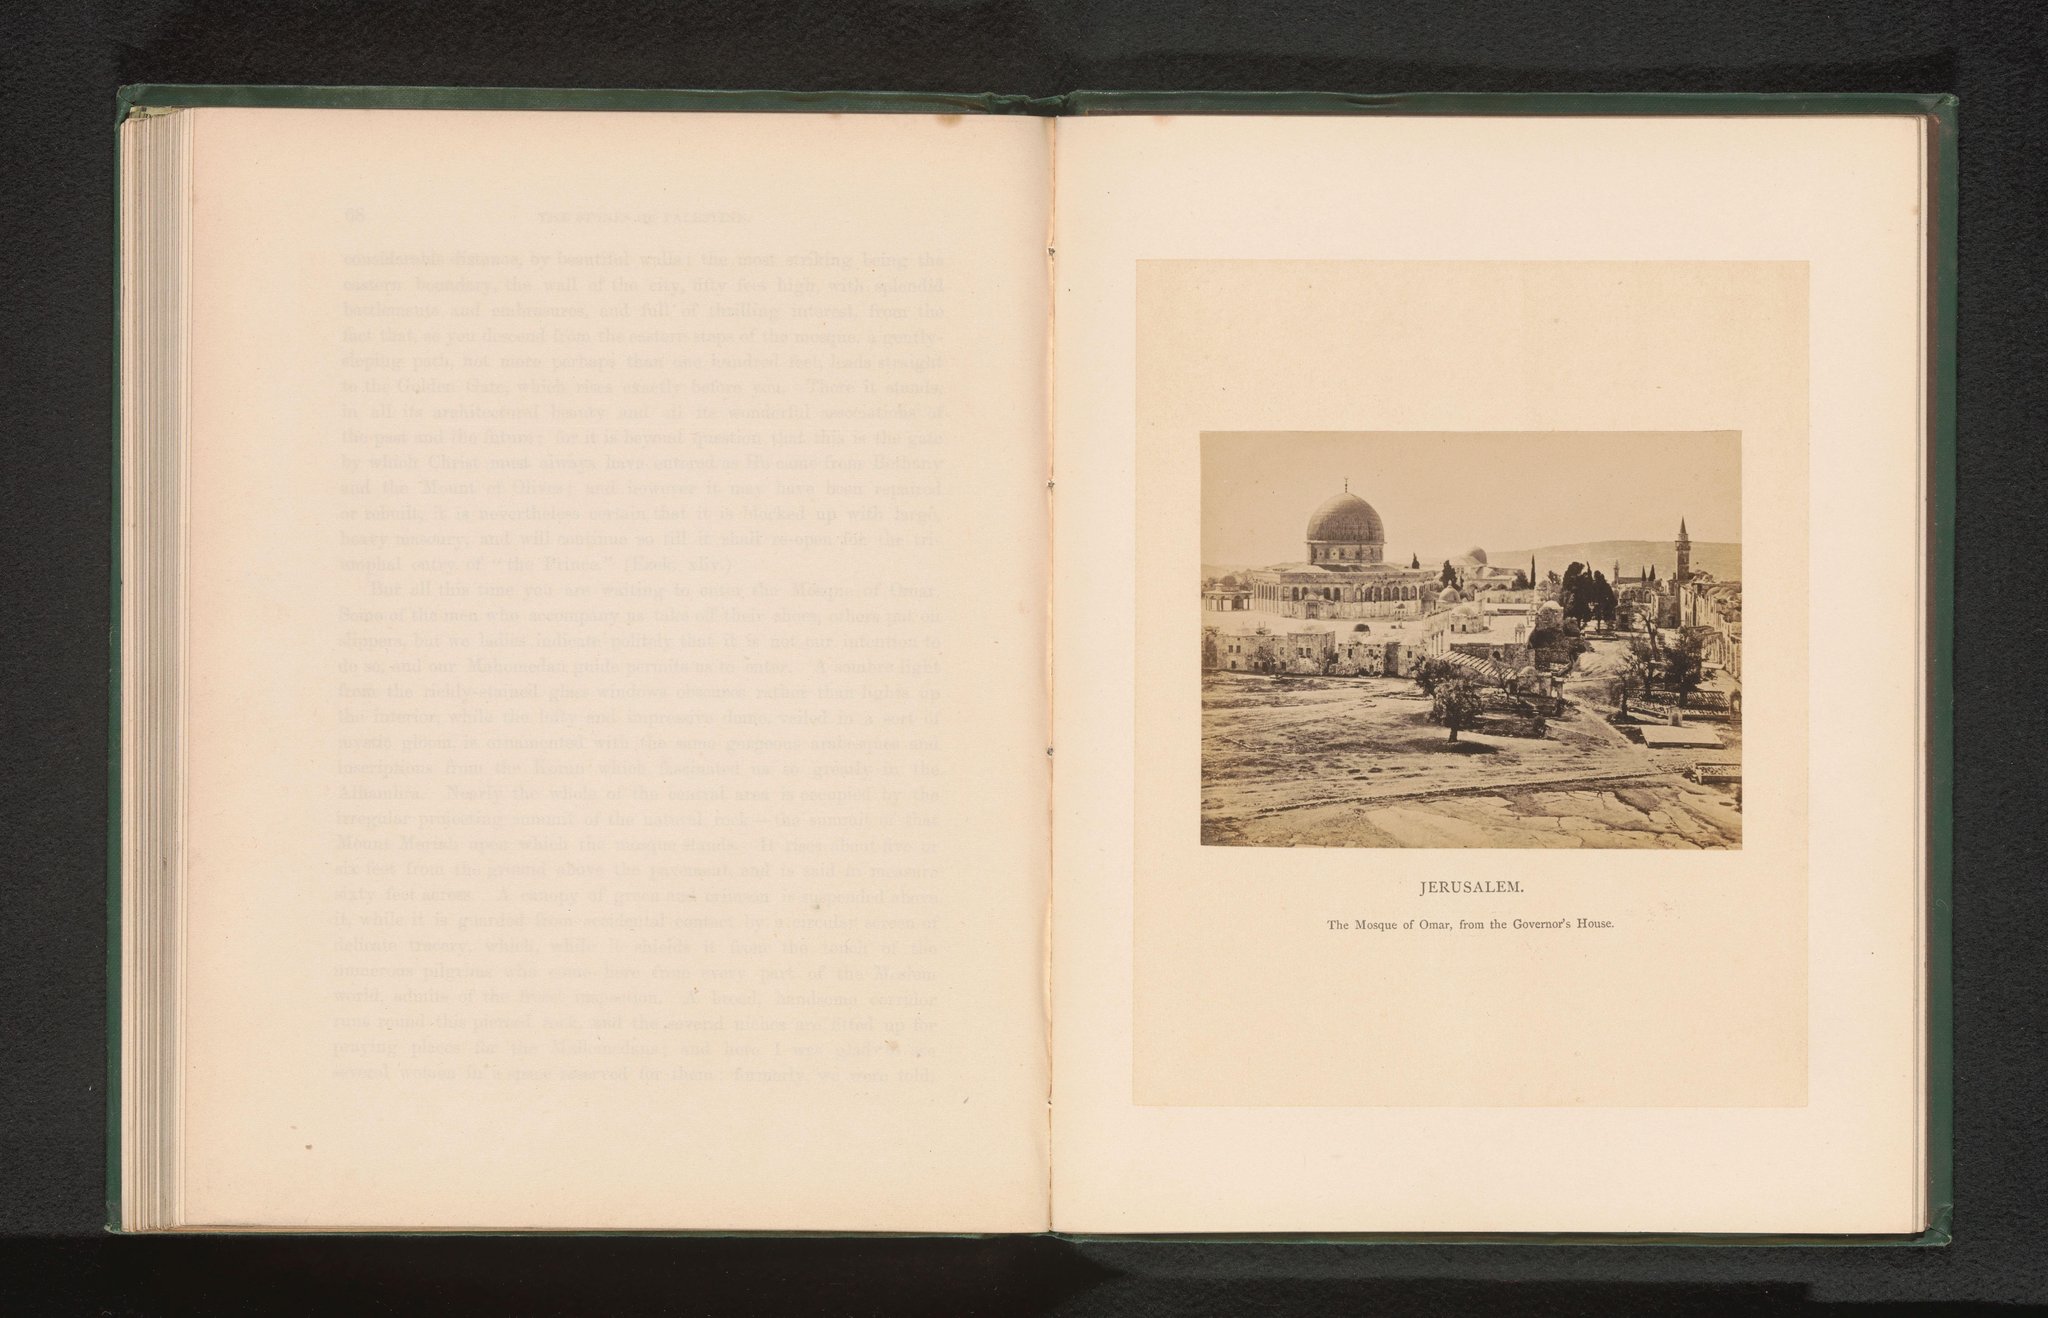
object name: page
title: Jerusalem. The Mosque of Omar, from the Governor's House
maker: francis bedford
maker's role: print maker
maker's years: 1815-1894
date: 1860-1865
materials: photographic support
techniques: albumen print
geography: jerusalem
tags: temple, shrine ~ islam, mohammedanism, façade (of house or building)